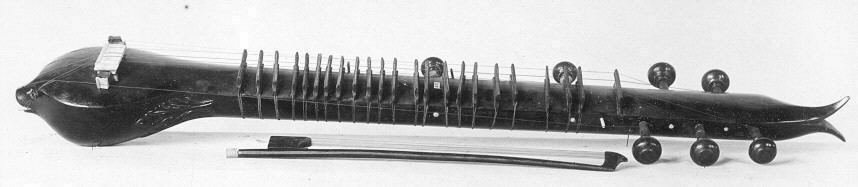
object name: benares vina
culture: indian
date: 1801-1900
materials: wood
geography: india